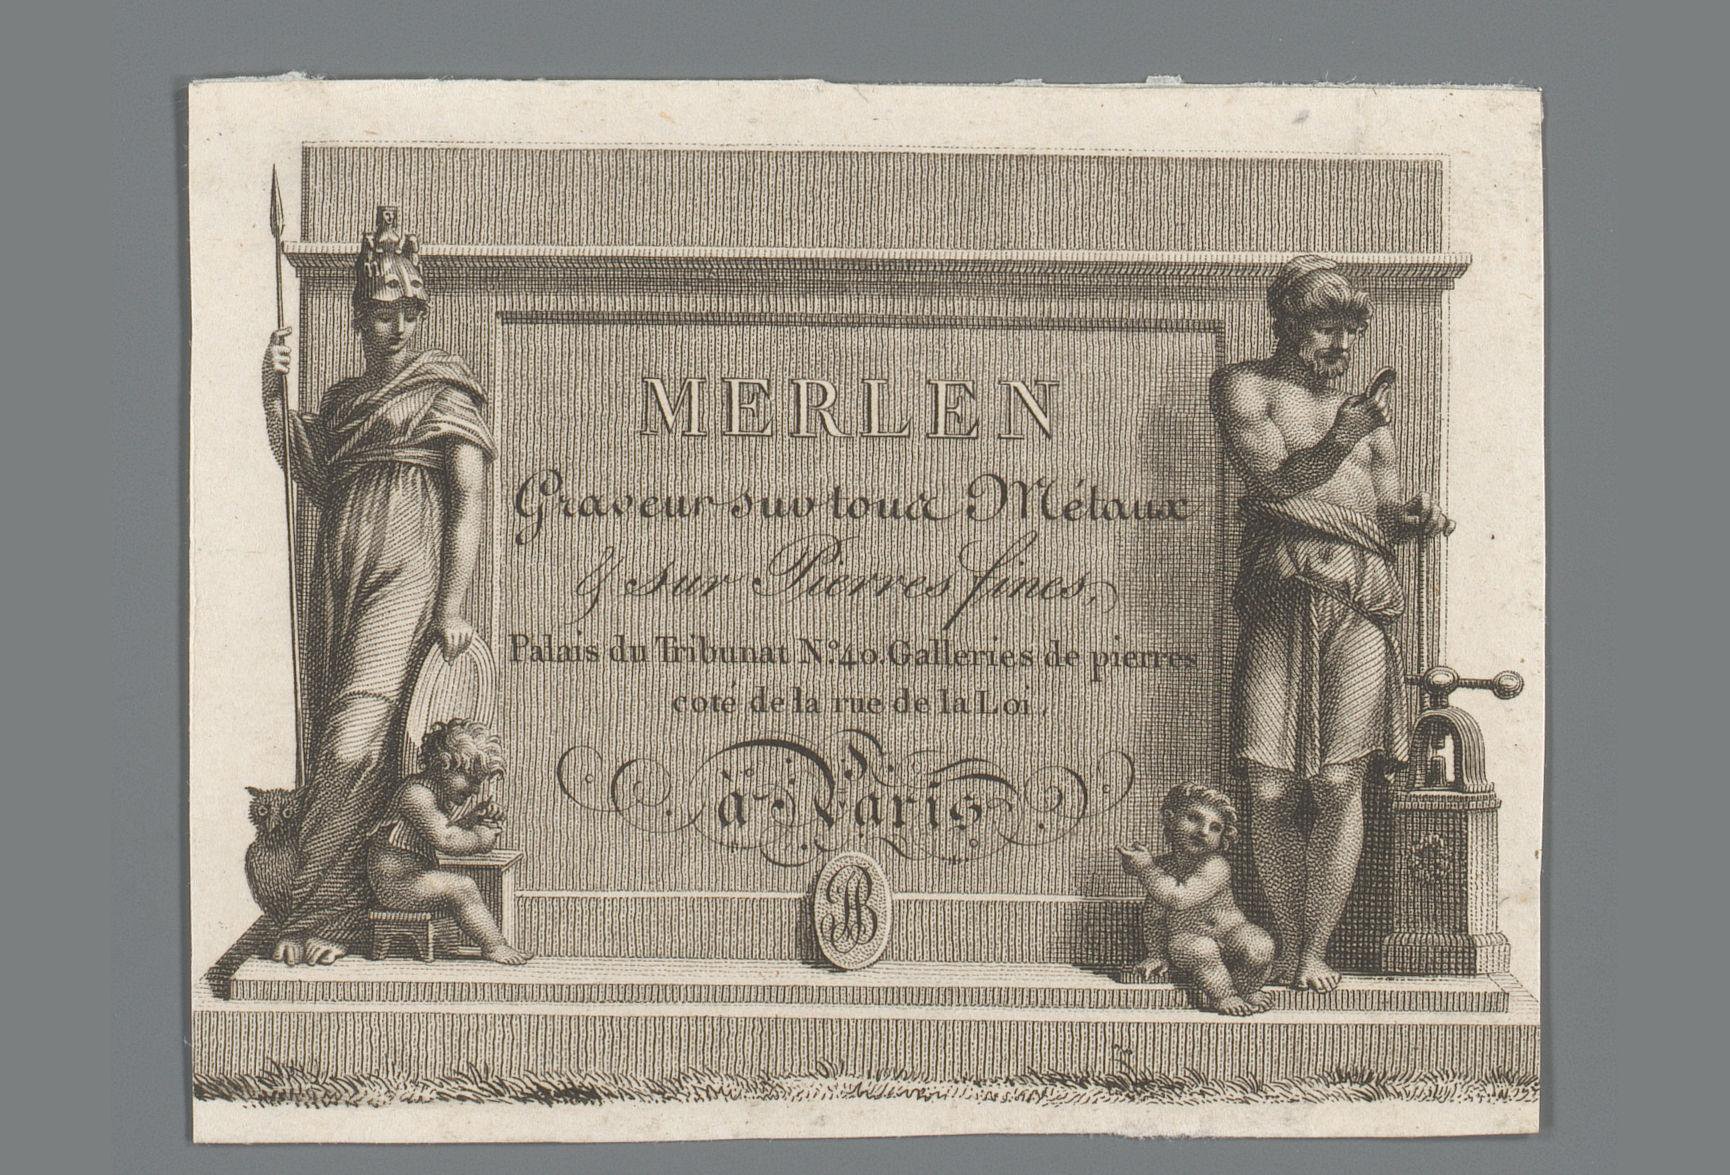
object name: visiting card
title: Visitekaart van graveur Jean Baptiste Merlen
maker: jean baptiste merlen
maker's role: graveur, medailleur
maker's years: 1769-1850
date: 1779-1850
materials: paper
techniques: engraving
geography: paris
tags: jean baptiste merlen, printing press, piece of sculpture, reproduction of a piece of sculpture, visiting-card, calling-card, paris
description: Twee klassieke standbeelden bij een sokkel. Naast een van de figuren een drukpers, verder twee putti. Op de sokkel: 'Merlen Graveur sur tous Métaux & sur Pierres fines' gevolgd door het adres.